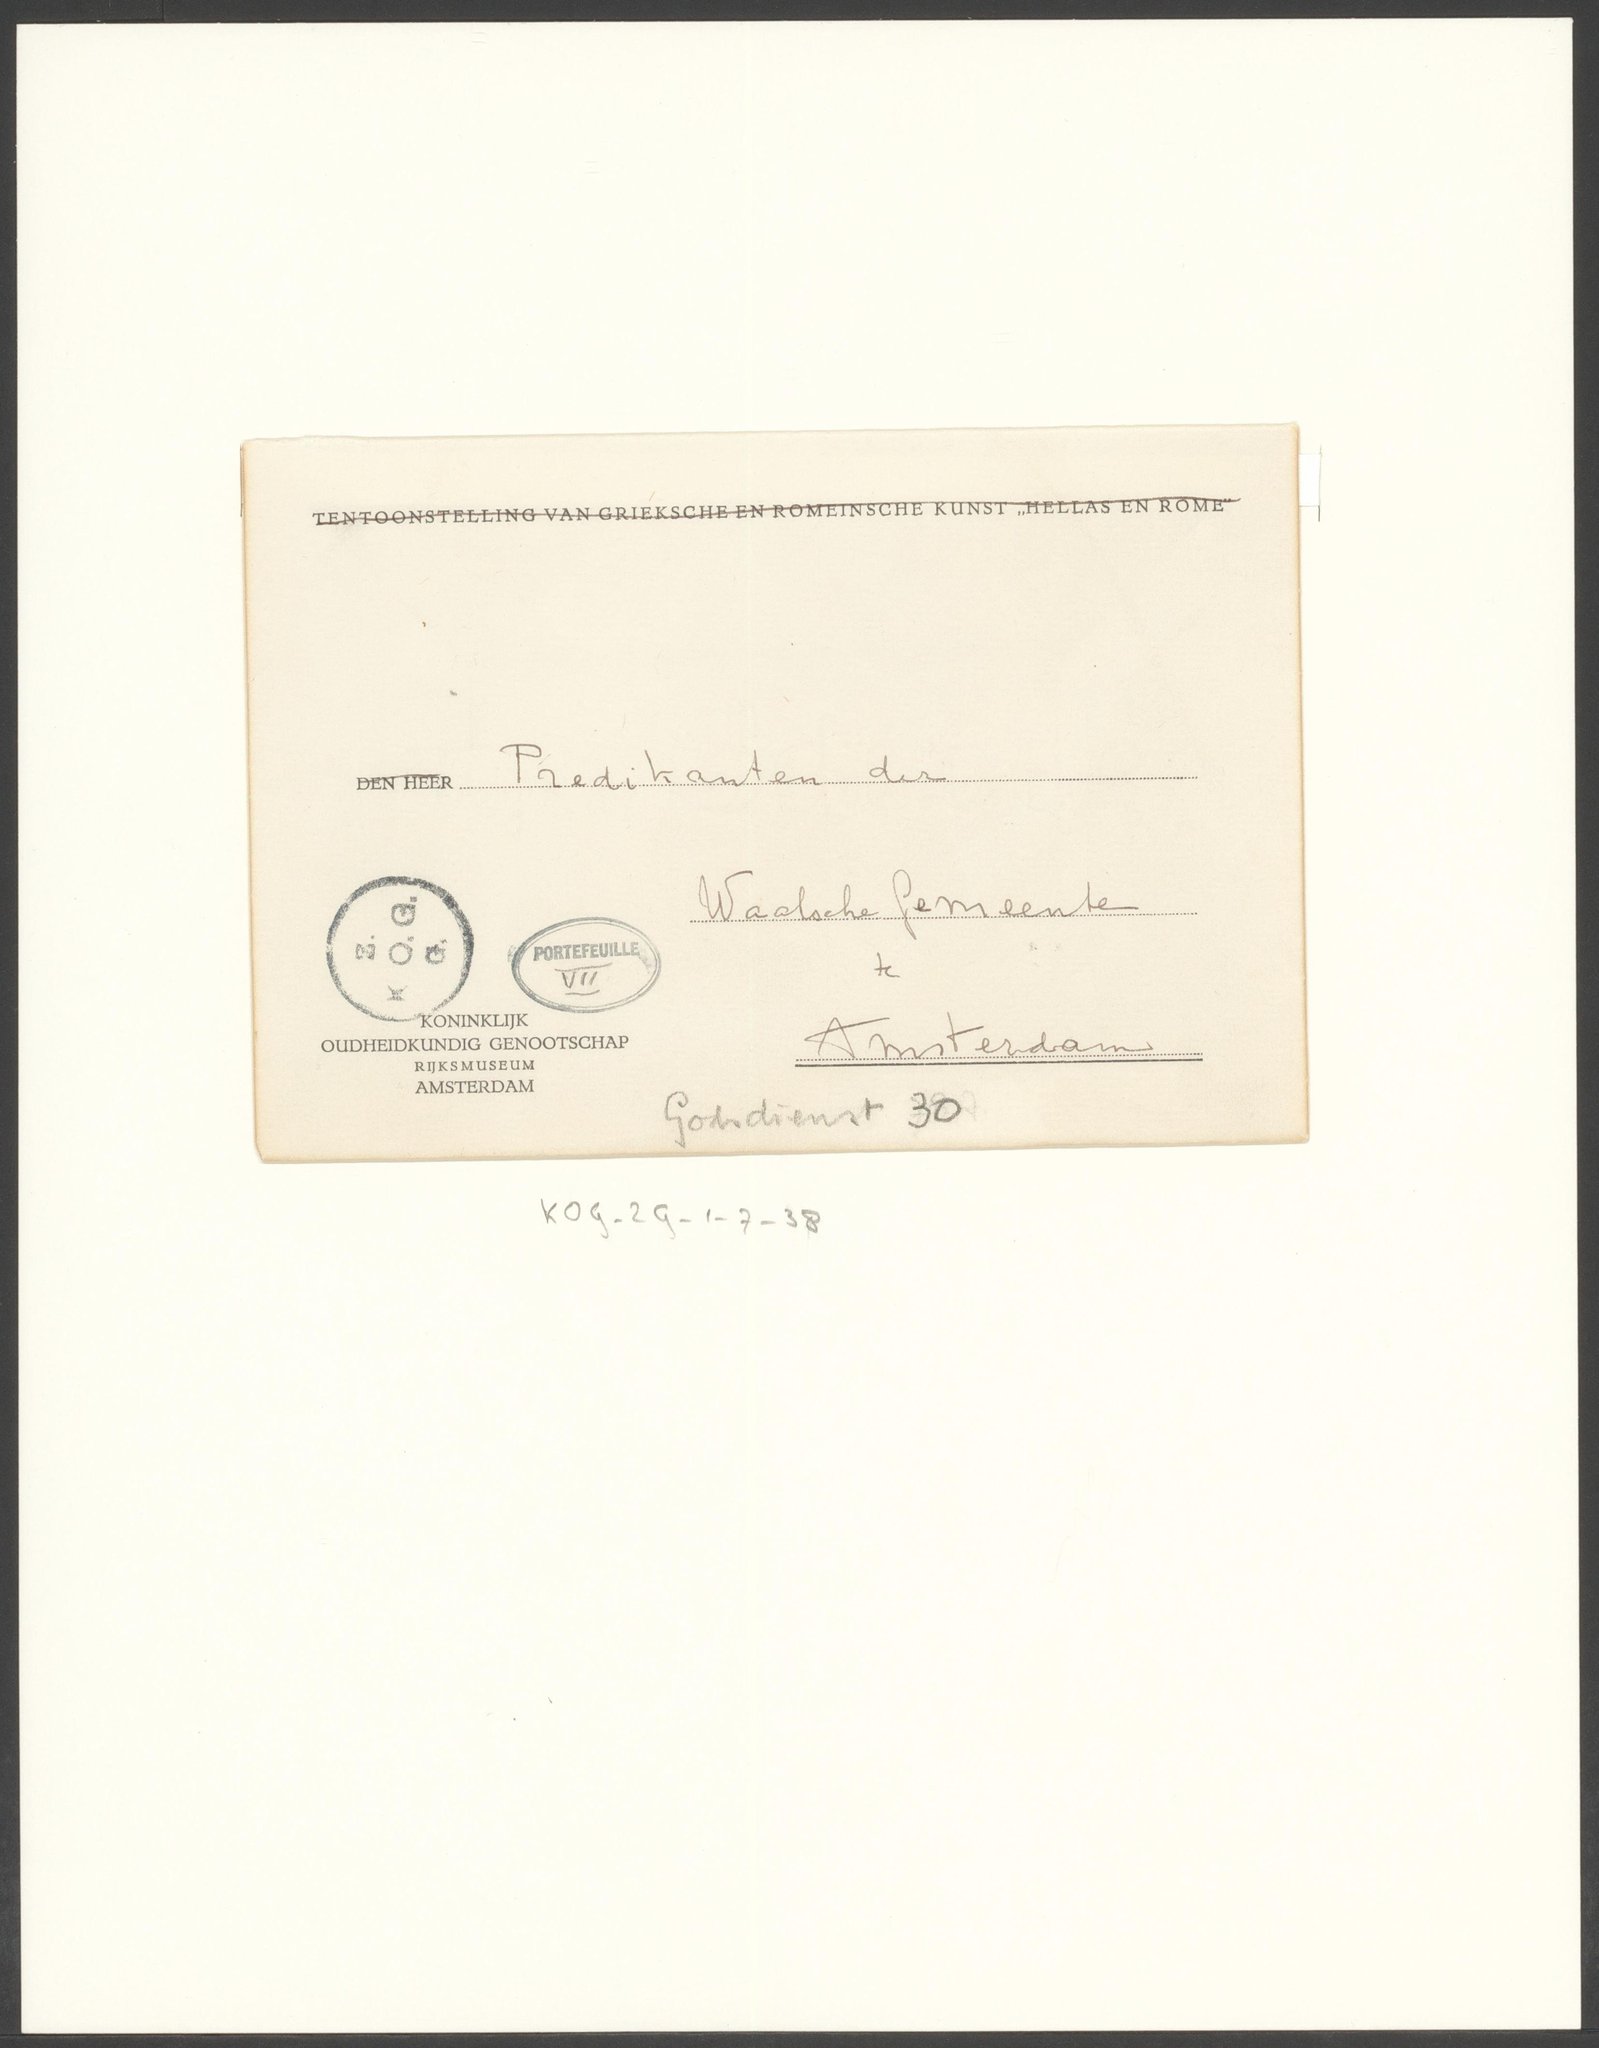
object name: text sheet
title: Handtekeningen van Predikanten van de Waalse gemeente te Amsterdam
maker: Anonymous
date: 1709-1727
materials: ink, paper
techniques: letterpress printing, pen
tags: amsterdam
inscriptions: collector's mark: Lugt 1641, stamp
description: Zestien losse handtekeningen van Predikanten van de Waalse Gemeente te Amsterdam tussen 1709 en 1727. Op sommige staat vellen alleen de handtekening op andere vellen staat een gedrukte tekst waar datum en handtekening met de hand zijn ingevuld. Onderwerpsrubrieken binnen de Atlas Zeden en Gewoonten: Godsdienst. Waalschen.